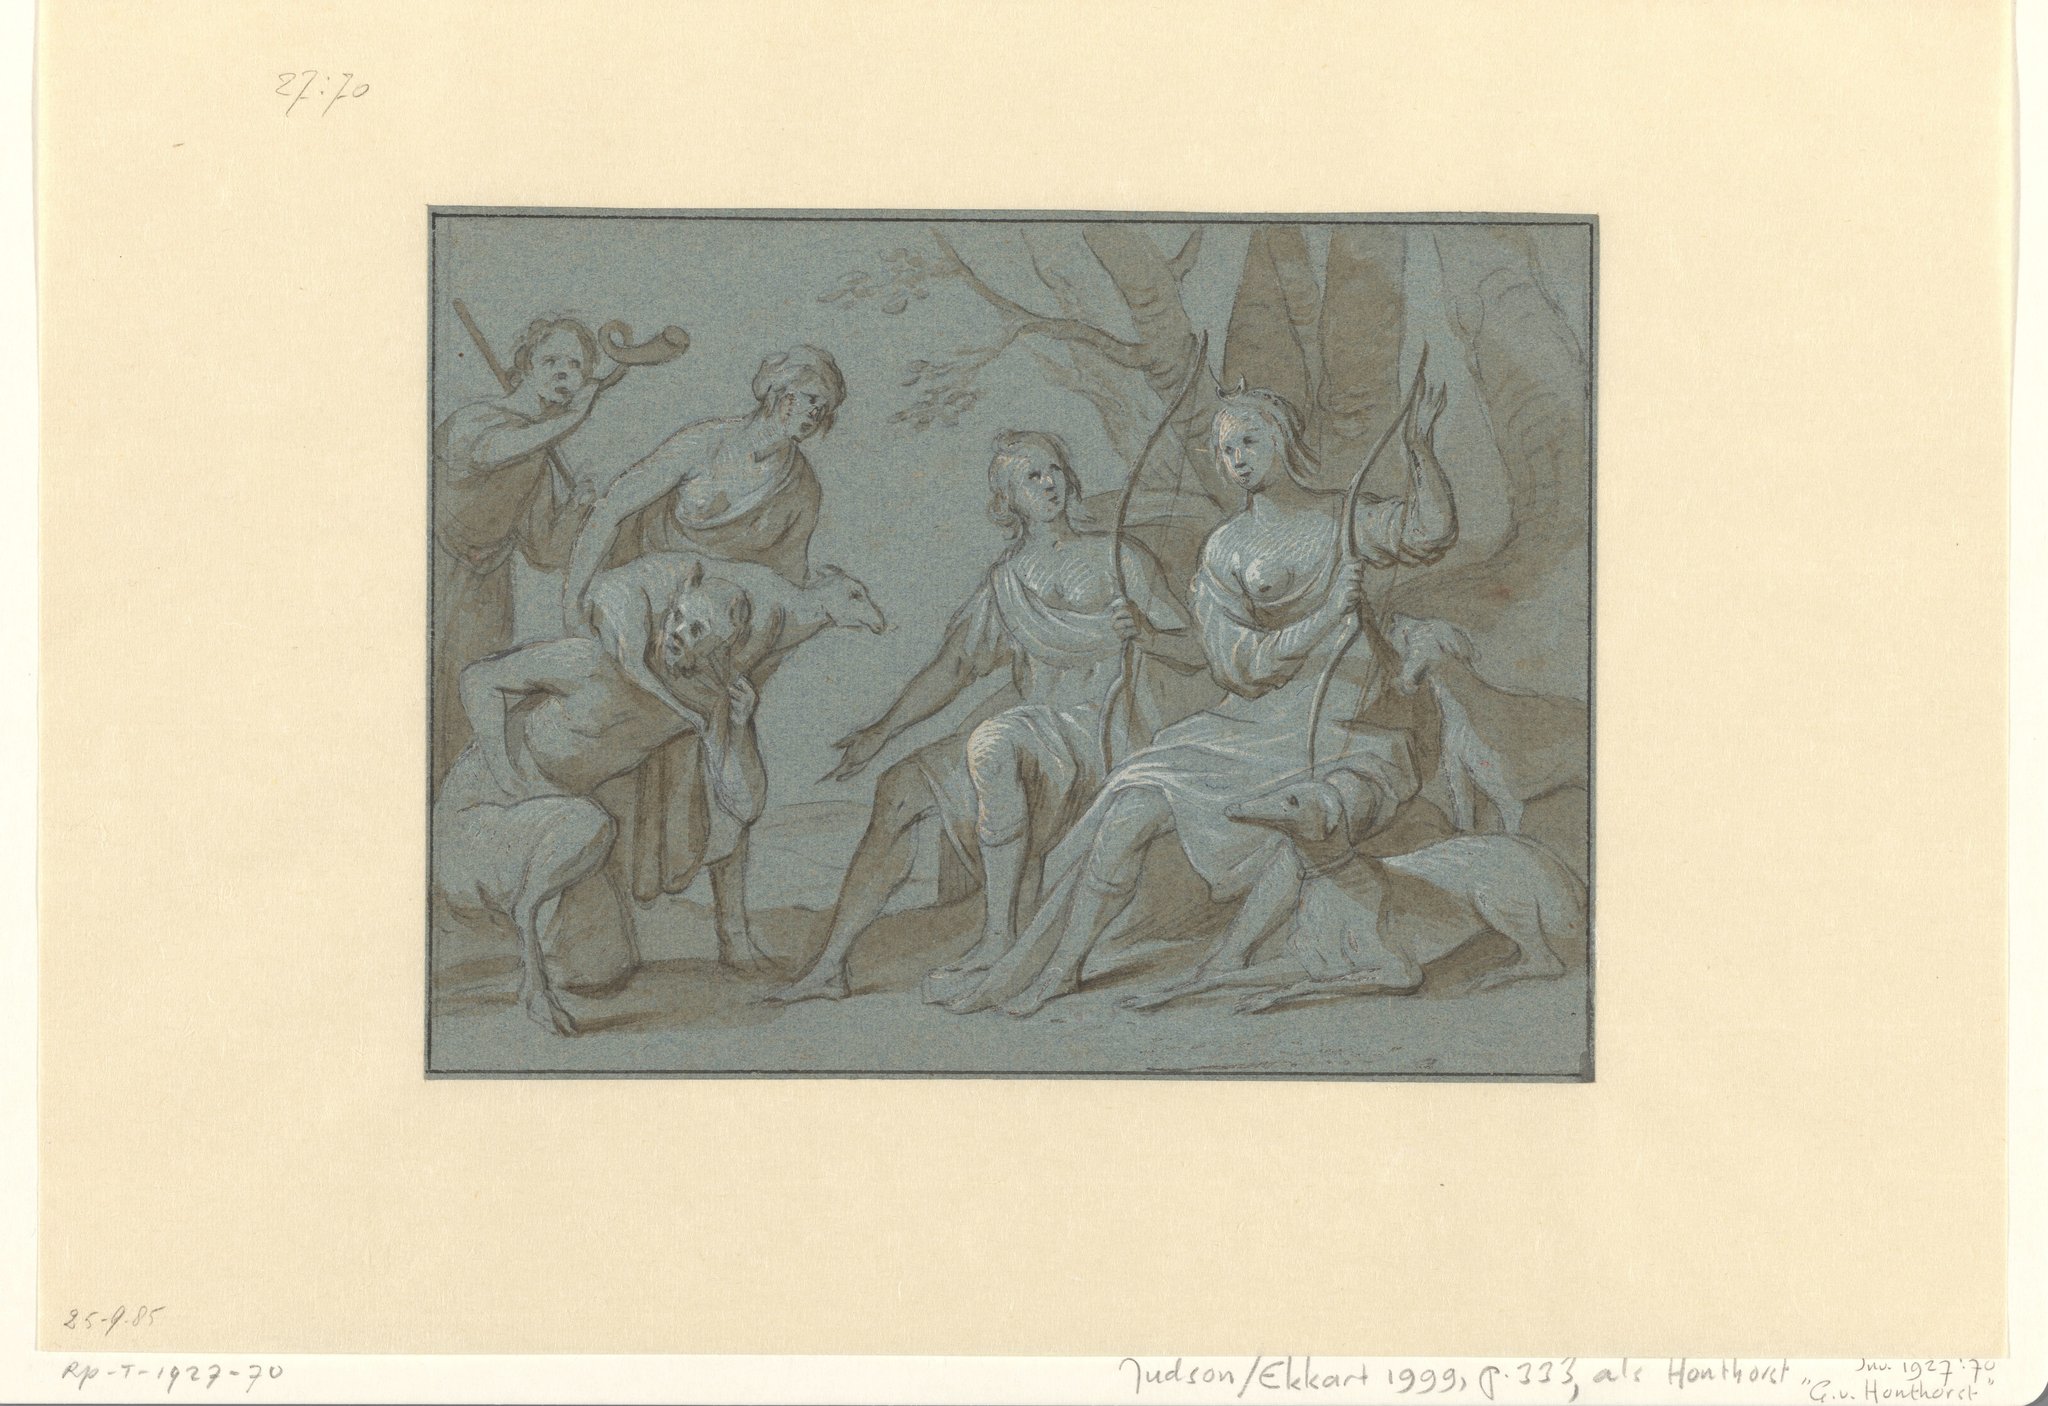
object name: drawing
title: Diana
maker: gerard van honthorst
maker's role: draughtsman, painter, print maker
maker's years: 1592-1656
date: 1600-1656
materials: chalk, paper, pencil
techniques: brush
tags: diana hunting, diana (luna) allured by pan with a fleece or a bundle of wool (virgil, 'georg.' iii 391-393)